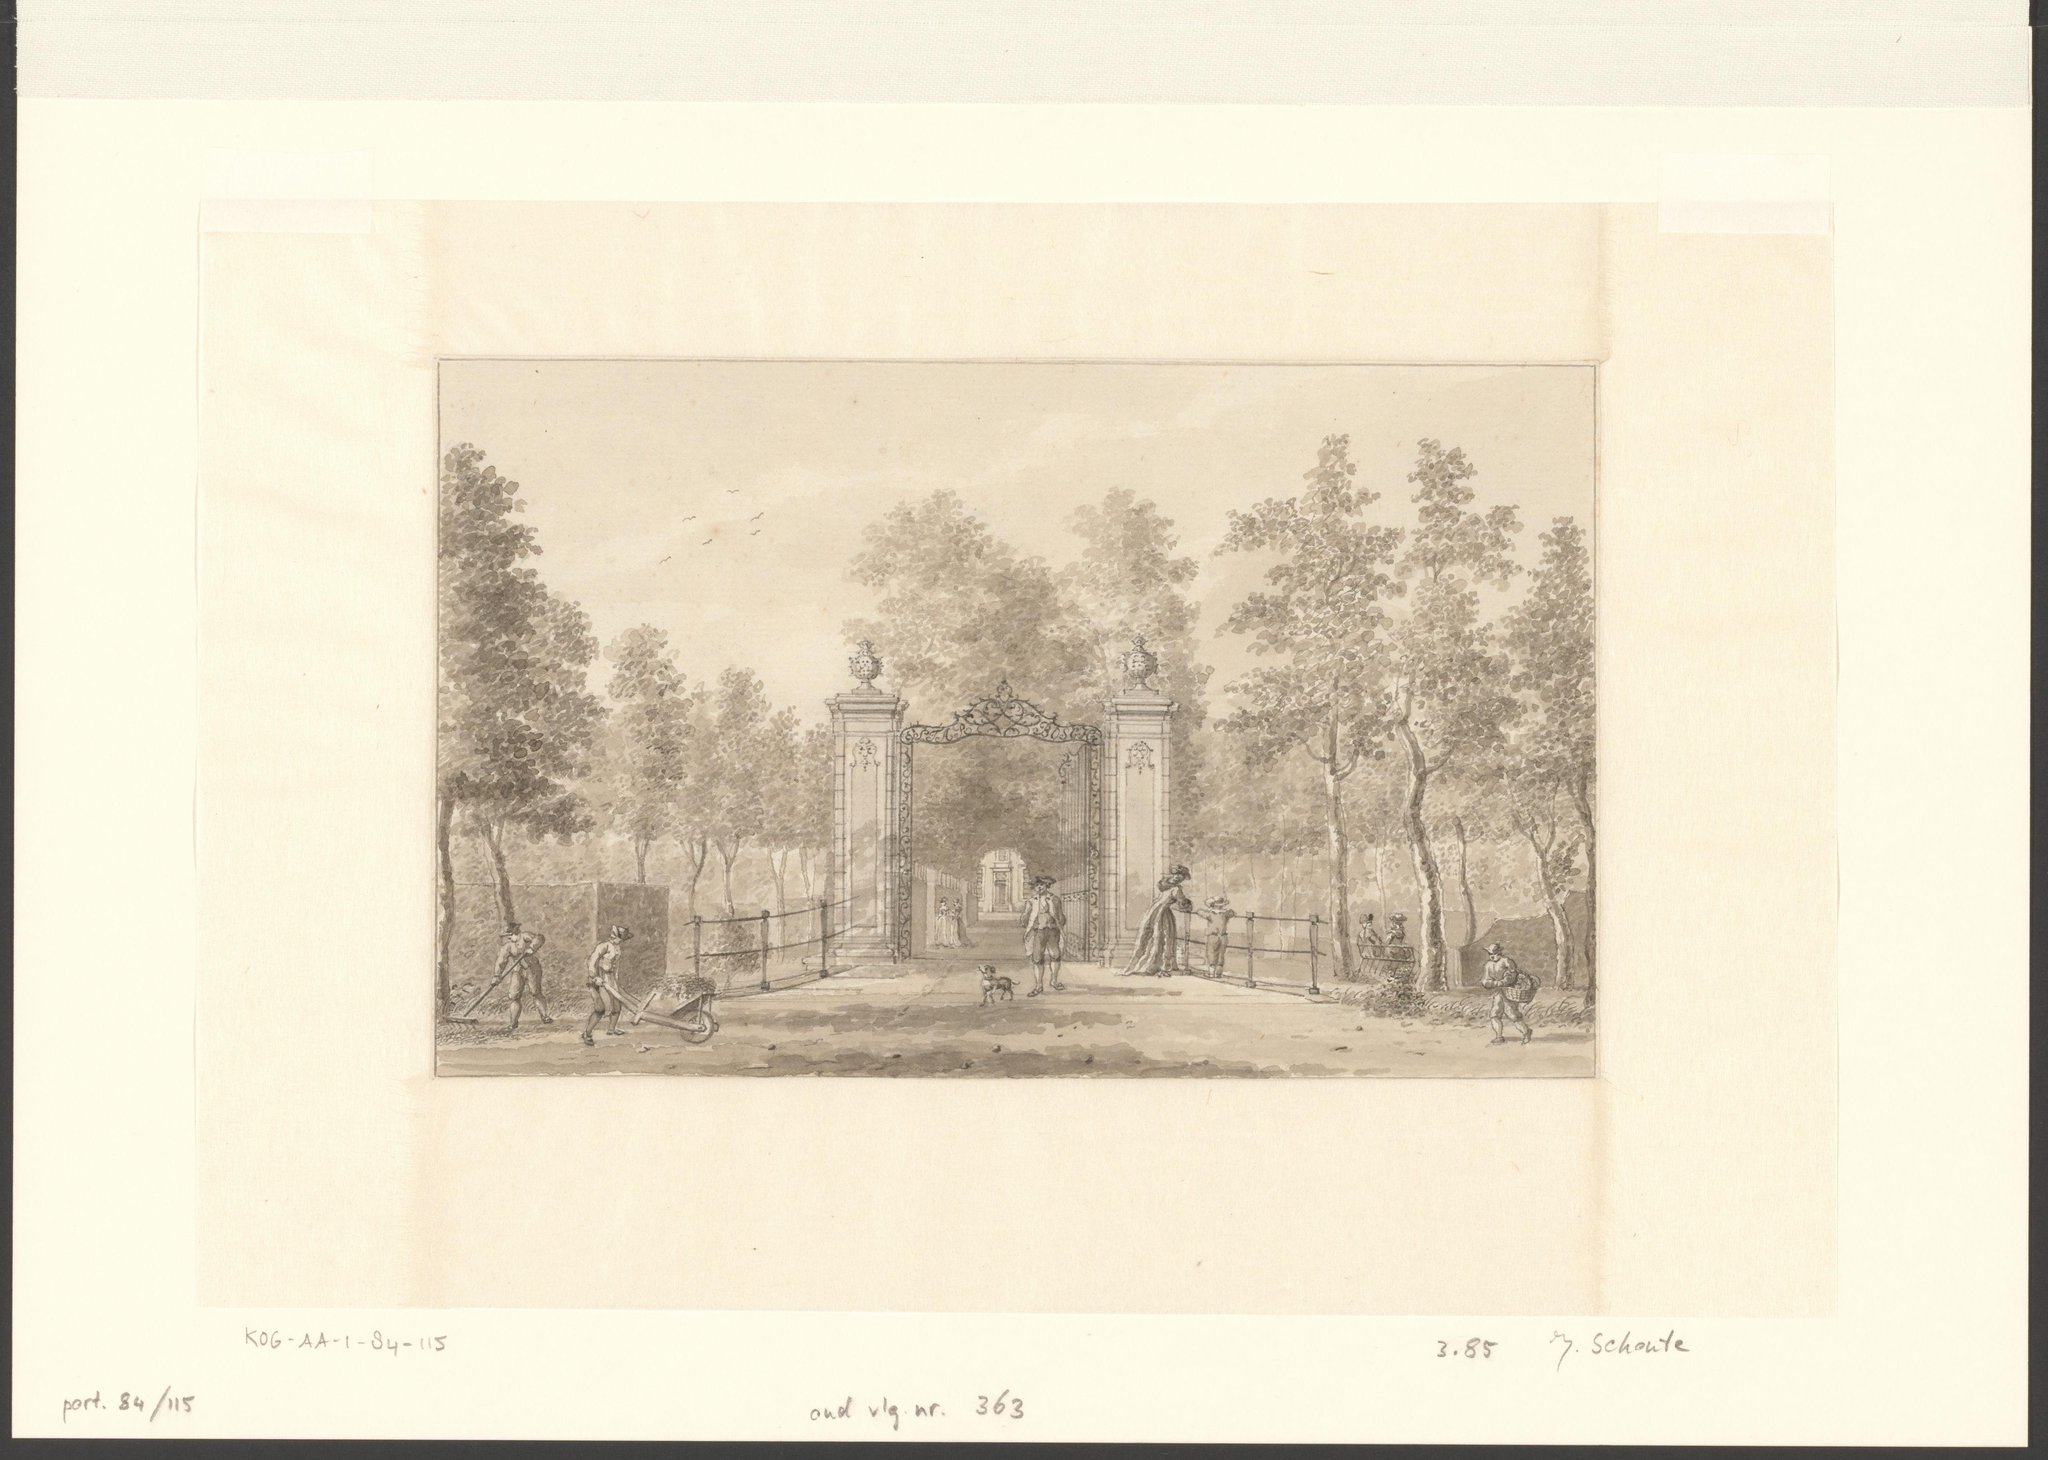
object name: drawing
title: Gezicht op de poort van buitenplaats Starrebos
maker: johannes schouten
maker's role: print maker, silversmith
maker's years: 1716-1792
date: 1731-1791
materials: ink, paper, pencil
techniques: brush, pen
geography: amsterdam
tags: city-view in general; 'veduta', rural housing, e.g. country-house, villa, cottage, gate, entrance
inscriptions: name: ‘J. Schoute’, inscription: ‘de Hofstede Star bosch in de kruys laan / van de diemermeer’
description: Onderwerpsrubriek binnen de Atlas Amsterdam: Diemer- of Watergraafsmeer.